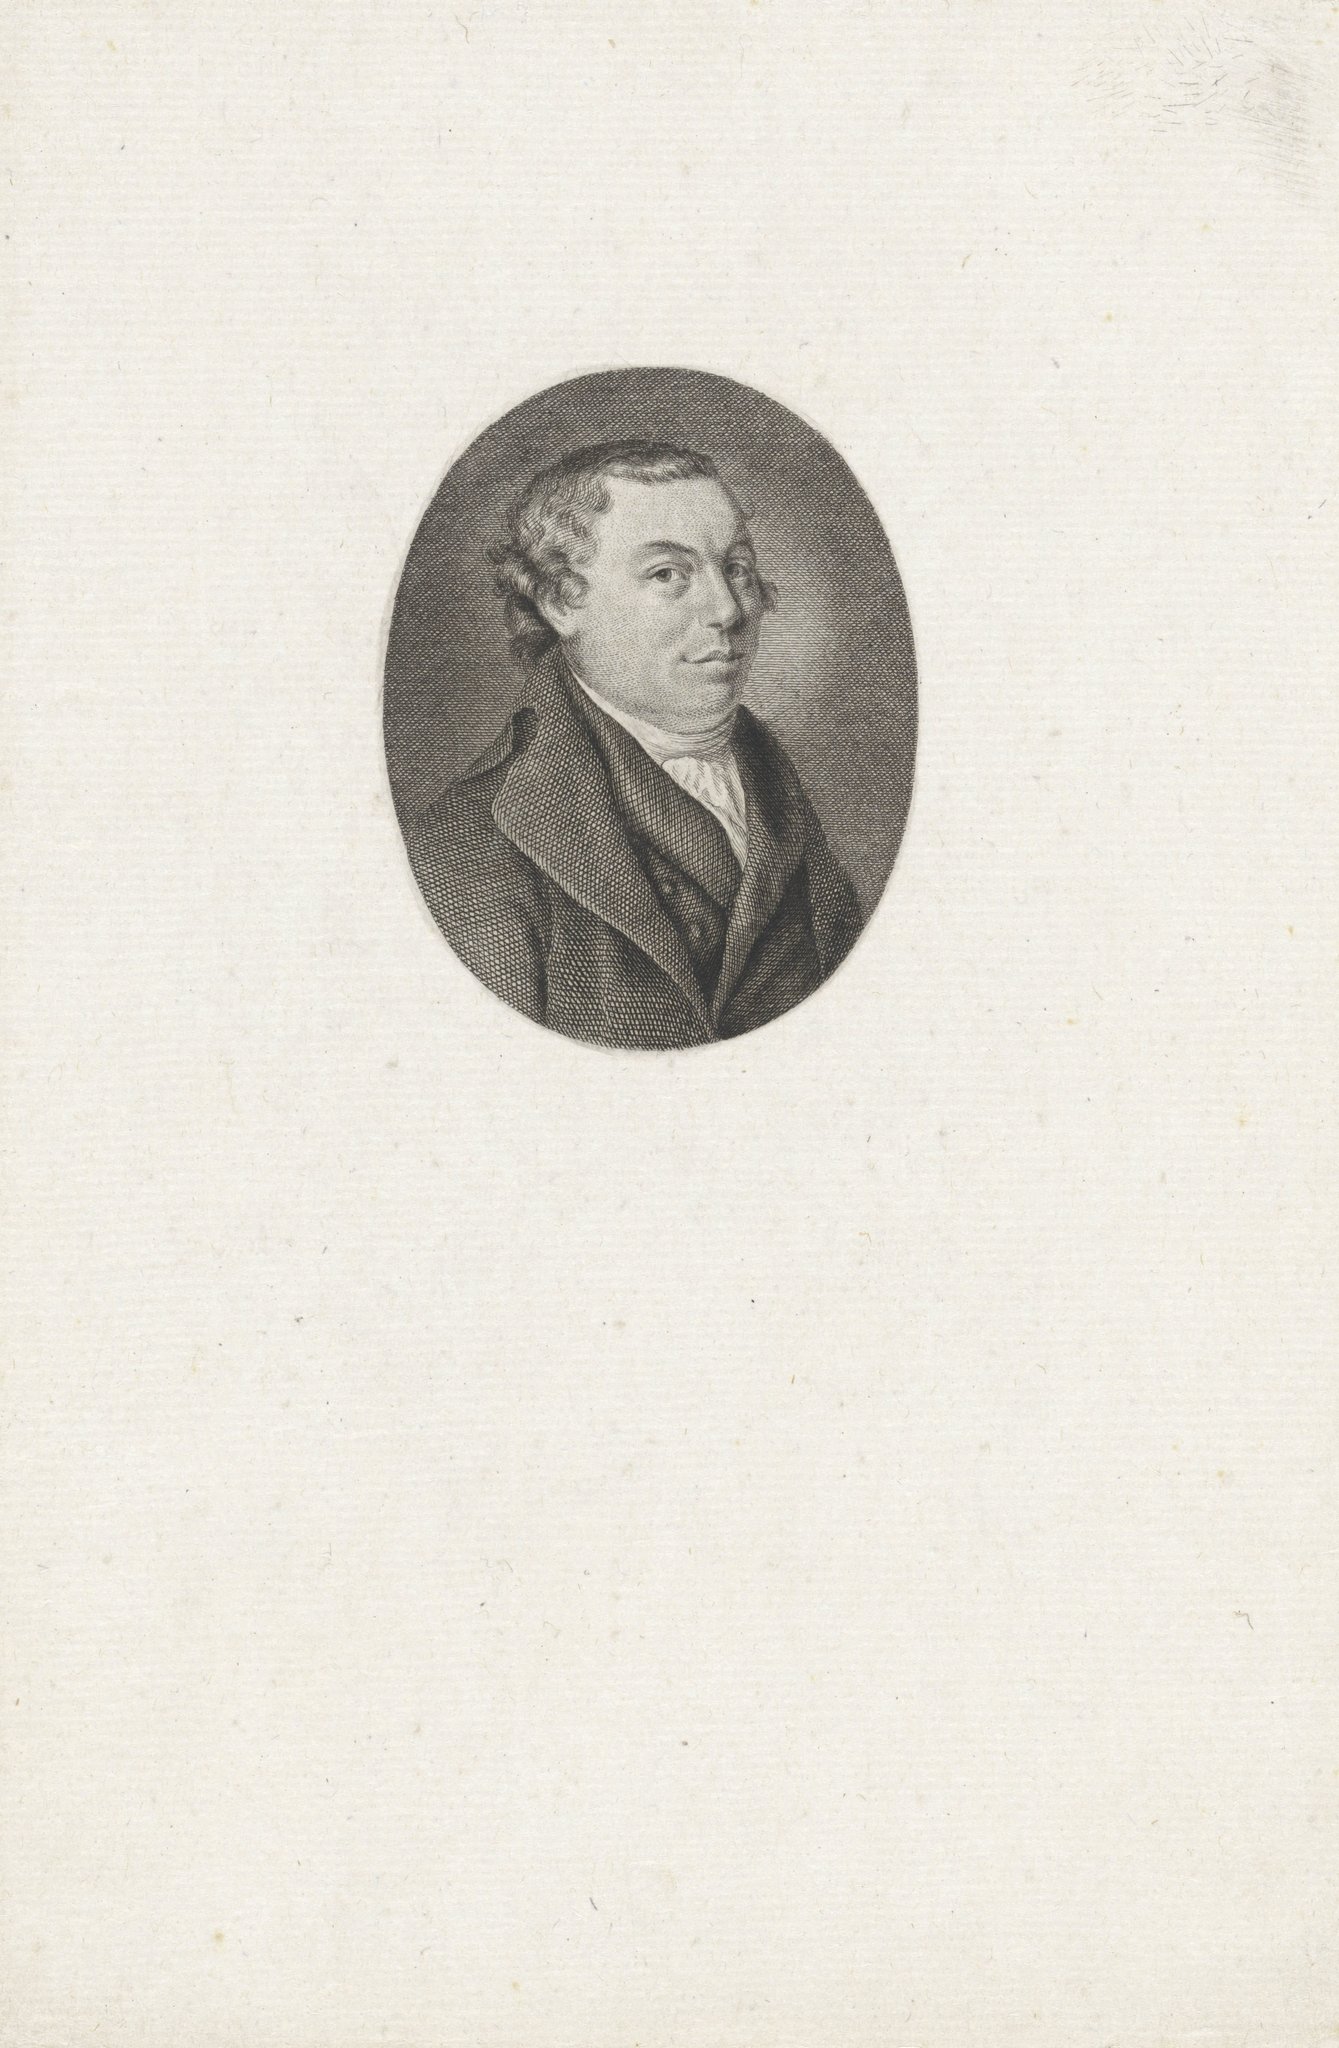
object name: print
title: Portret van Adriaan Pietersz. Loosjes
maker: reinier vinkeles (i)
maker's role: draughtsman, print maker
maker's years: 1741-1816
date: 1796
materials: paper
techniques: engraving, etching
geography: amsterdam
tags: haarlem, publisher, bookseller, adriaan pietersz. loosjes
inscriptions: collector's mark: Lugt 2228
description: Latere staat prent ook gebruikt als boekillustratie in: Wagenaar, Jan. Vaderlandsche historie, (...) ten vervolge van Wagenaars Vaderlandsche historie. Dl. 1-43. Amsterdam: Johannes Allart, 1786-1809.